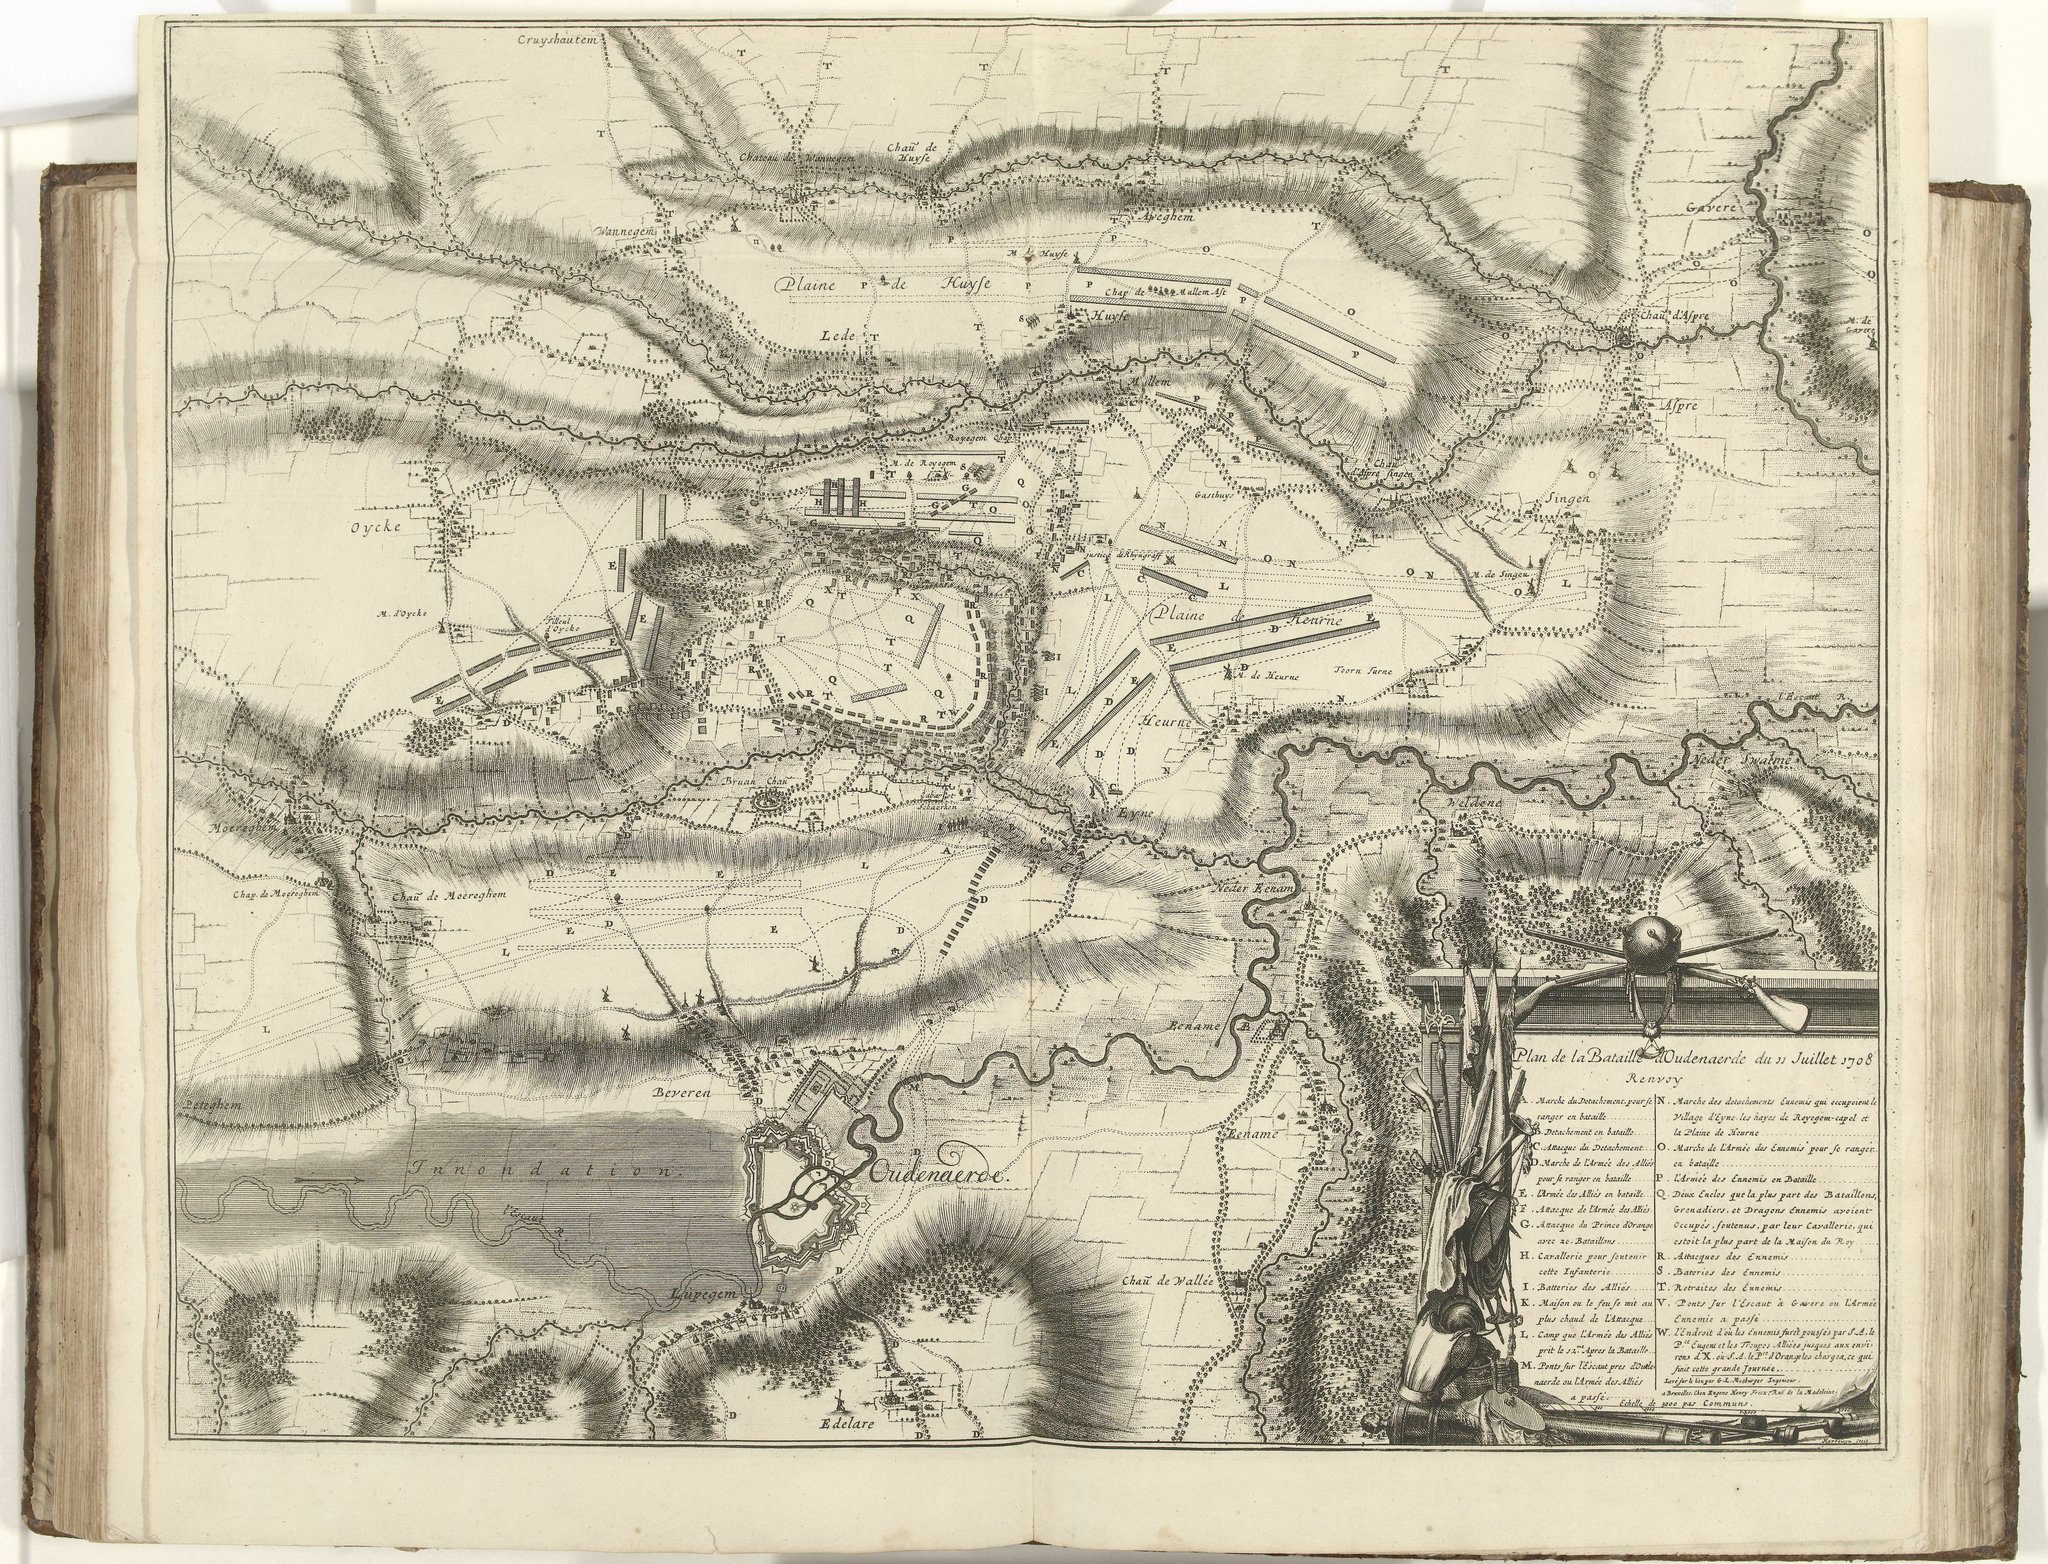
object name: print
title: Plan de la Bataille d'Oudenaerde du 11 Juillet 1708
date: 1708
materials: paper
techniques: etching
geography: brussels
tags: maps of separate countries or regions, battle (+ land forces)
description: Plan van de veldslag bij Oudenaarde tussen de Geallieerden onder de prins van Savoye en de hertog van Marlborough en de Fransen, 11 juli 1708. Rechtsonder een cartouche versierd met wapens met de legenda A-V in het Frans. Onderdeel van een gebundelde verzameling van plannen van veldslagen en steden vermaard in de Spaanse Successieoorlog.